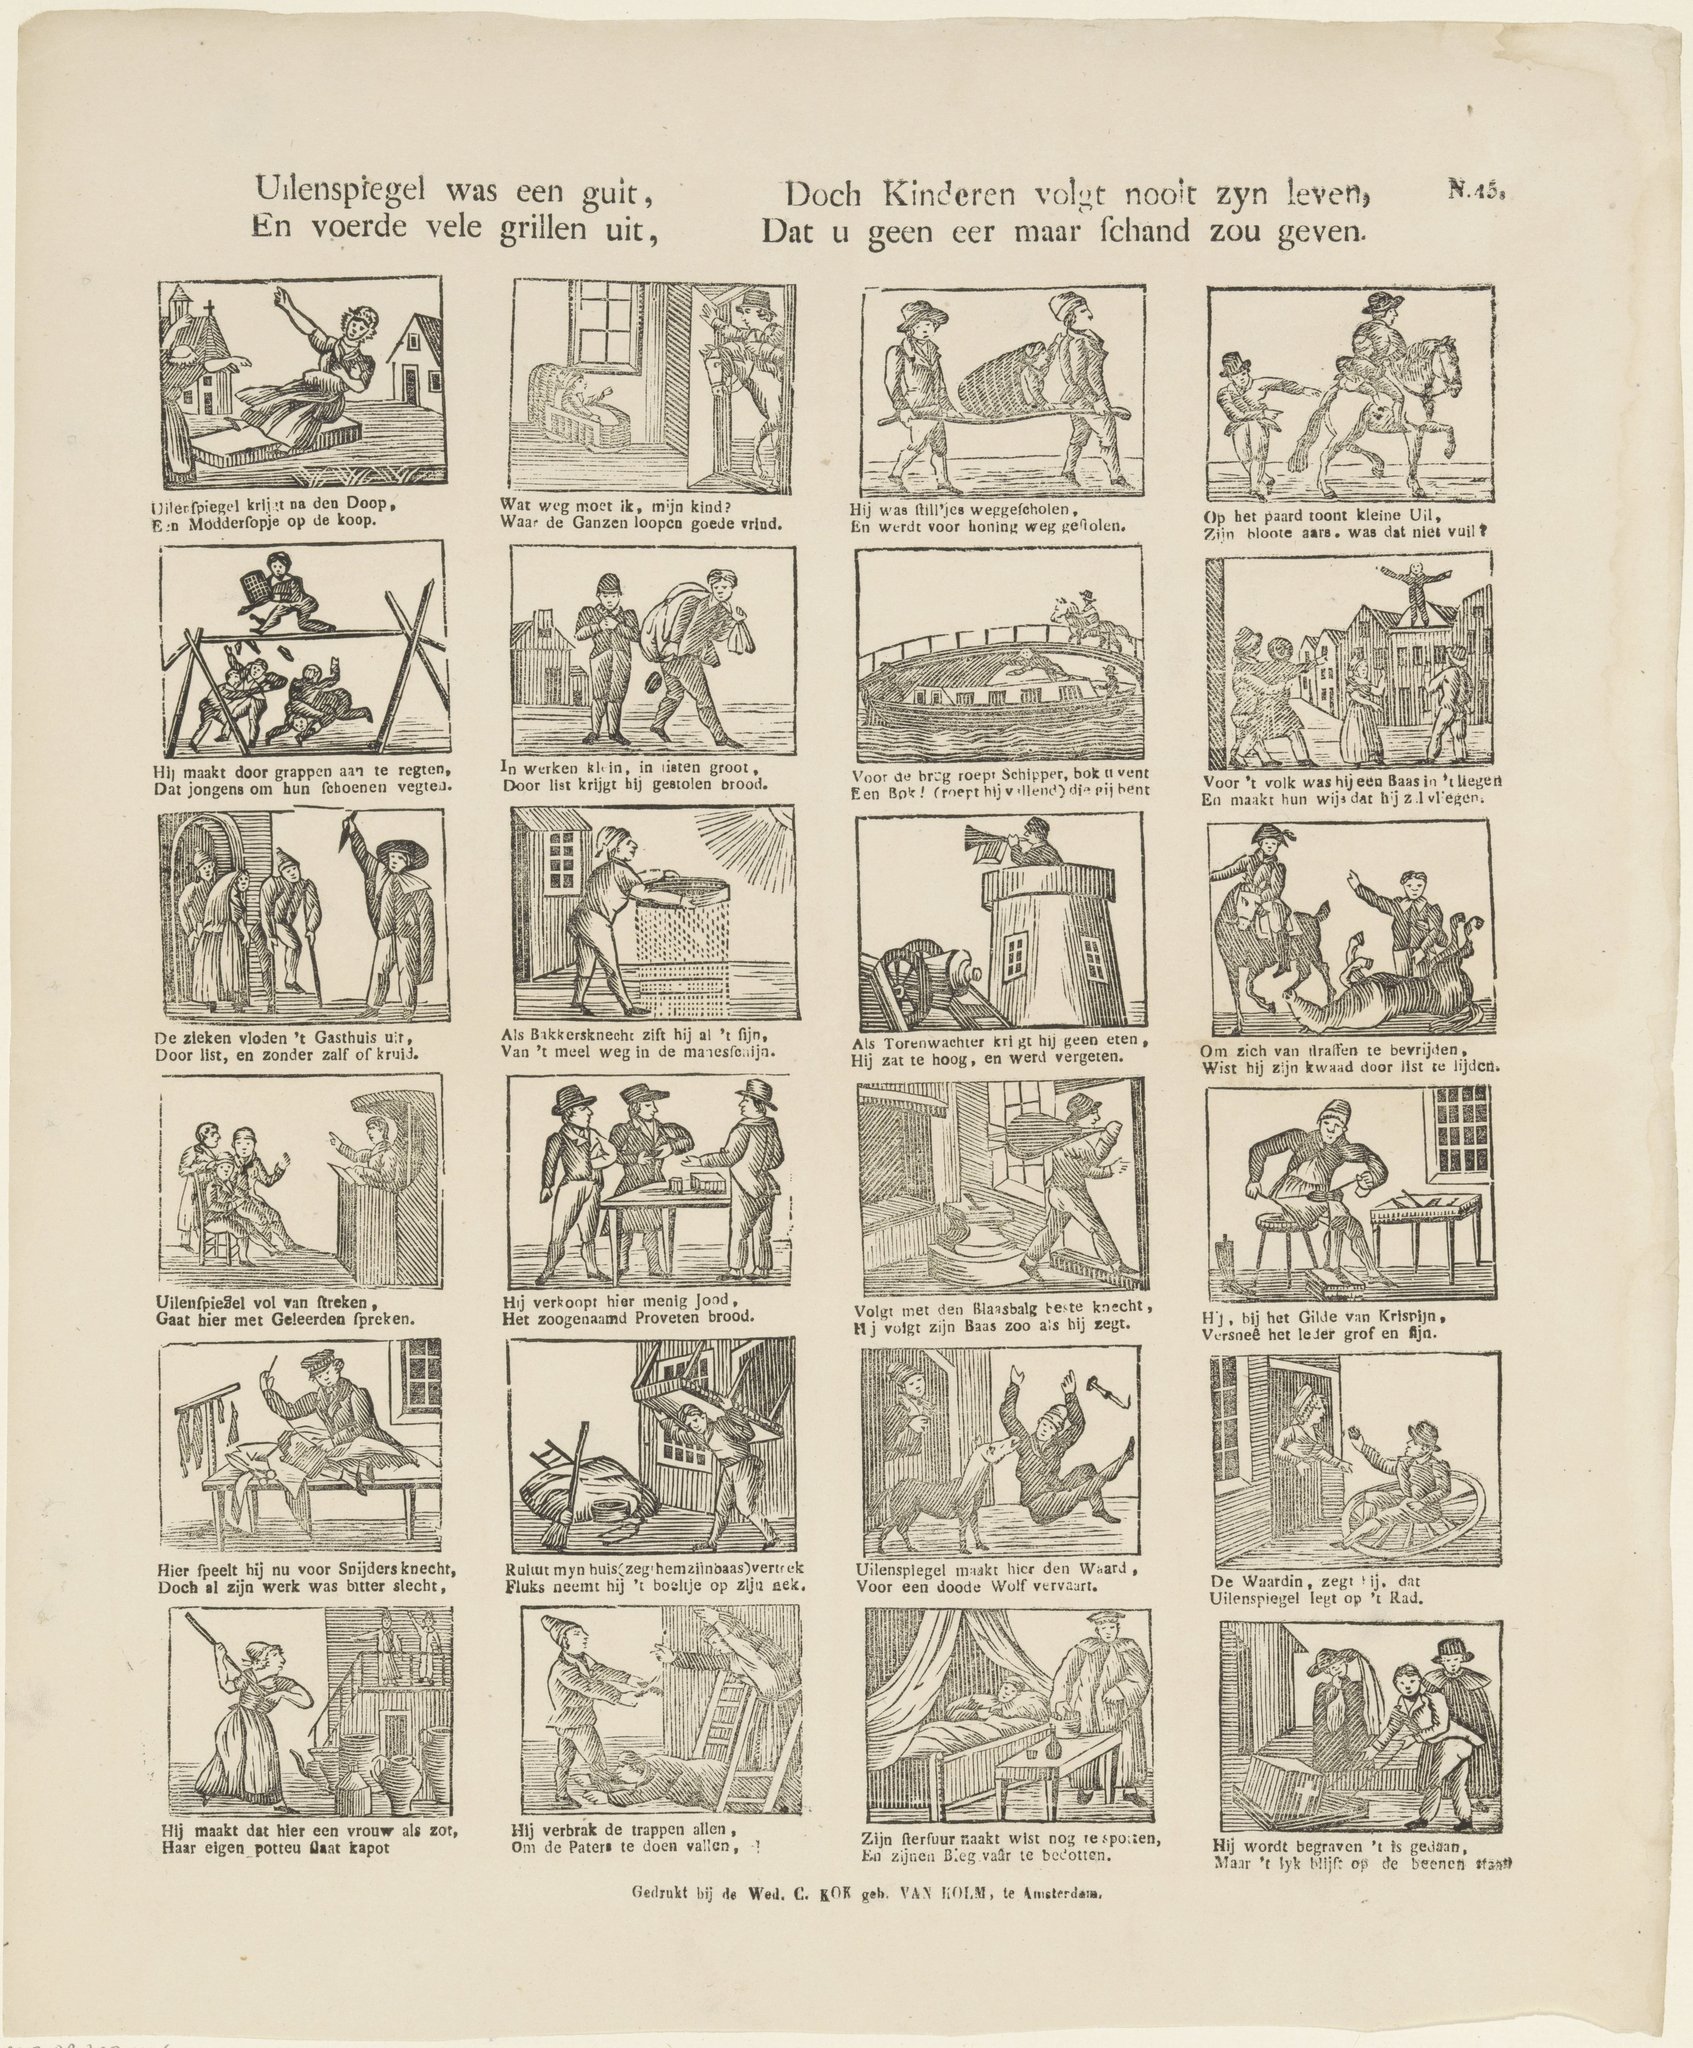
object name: popular print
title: Uilenspiegel was een guit, / En voerde vele grillen uit, / Doch kinderen volgt nooit zyn leven, / Dat u geen eer maar schand zou geven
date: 1842-1866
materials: paper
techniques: letterpress printing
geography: netherlands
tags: eulenspiegel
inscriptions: collector's mark: Lugt 2760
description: Blad met 24 voorstellingen over het leven van Tijl Uilenspiegel. Onder elke afbeelding een tweeregelig vers. Genummerd rechtsboven: No. 45.